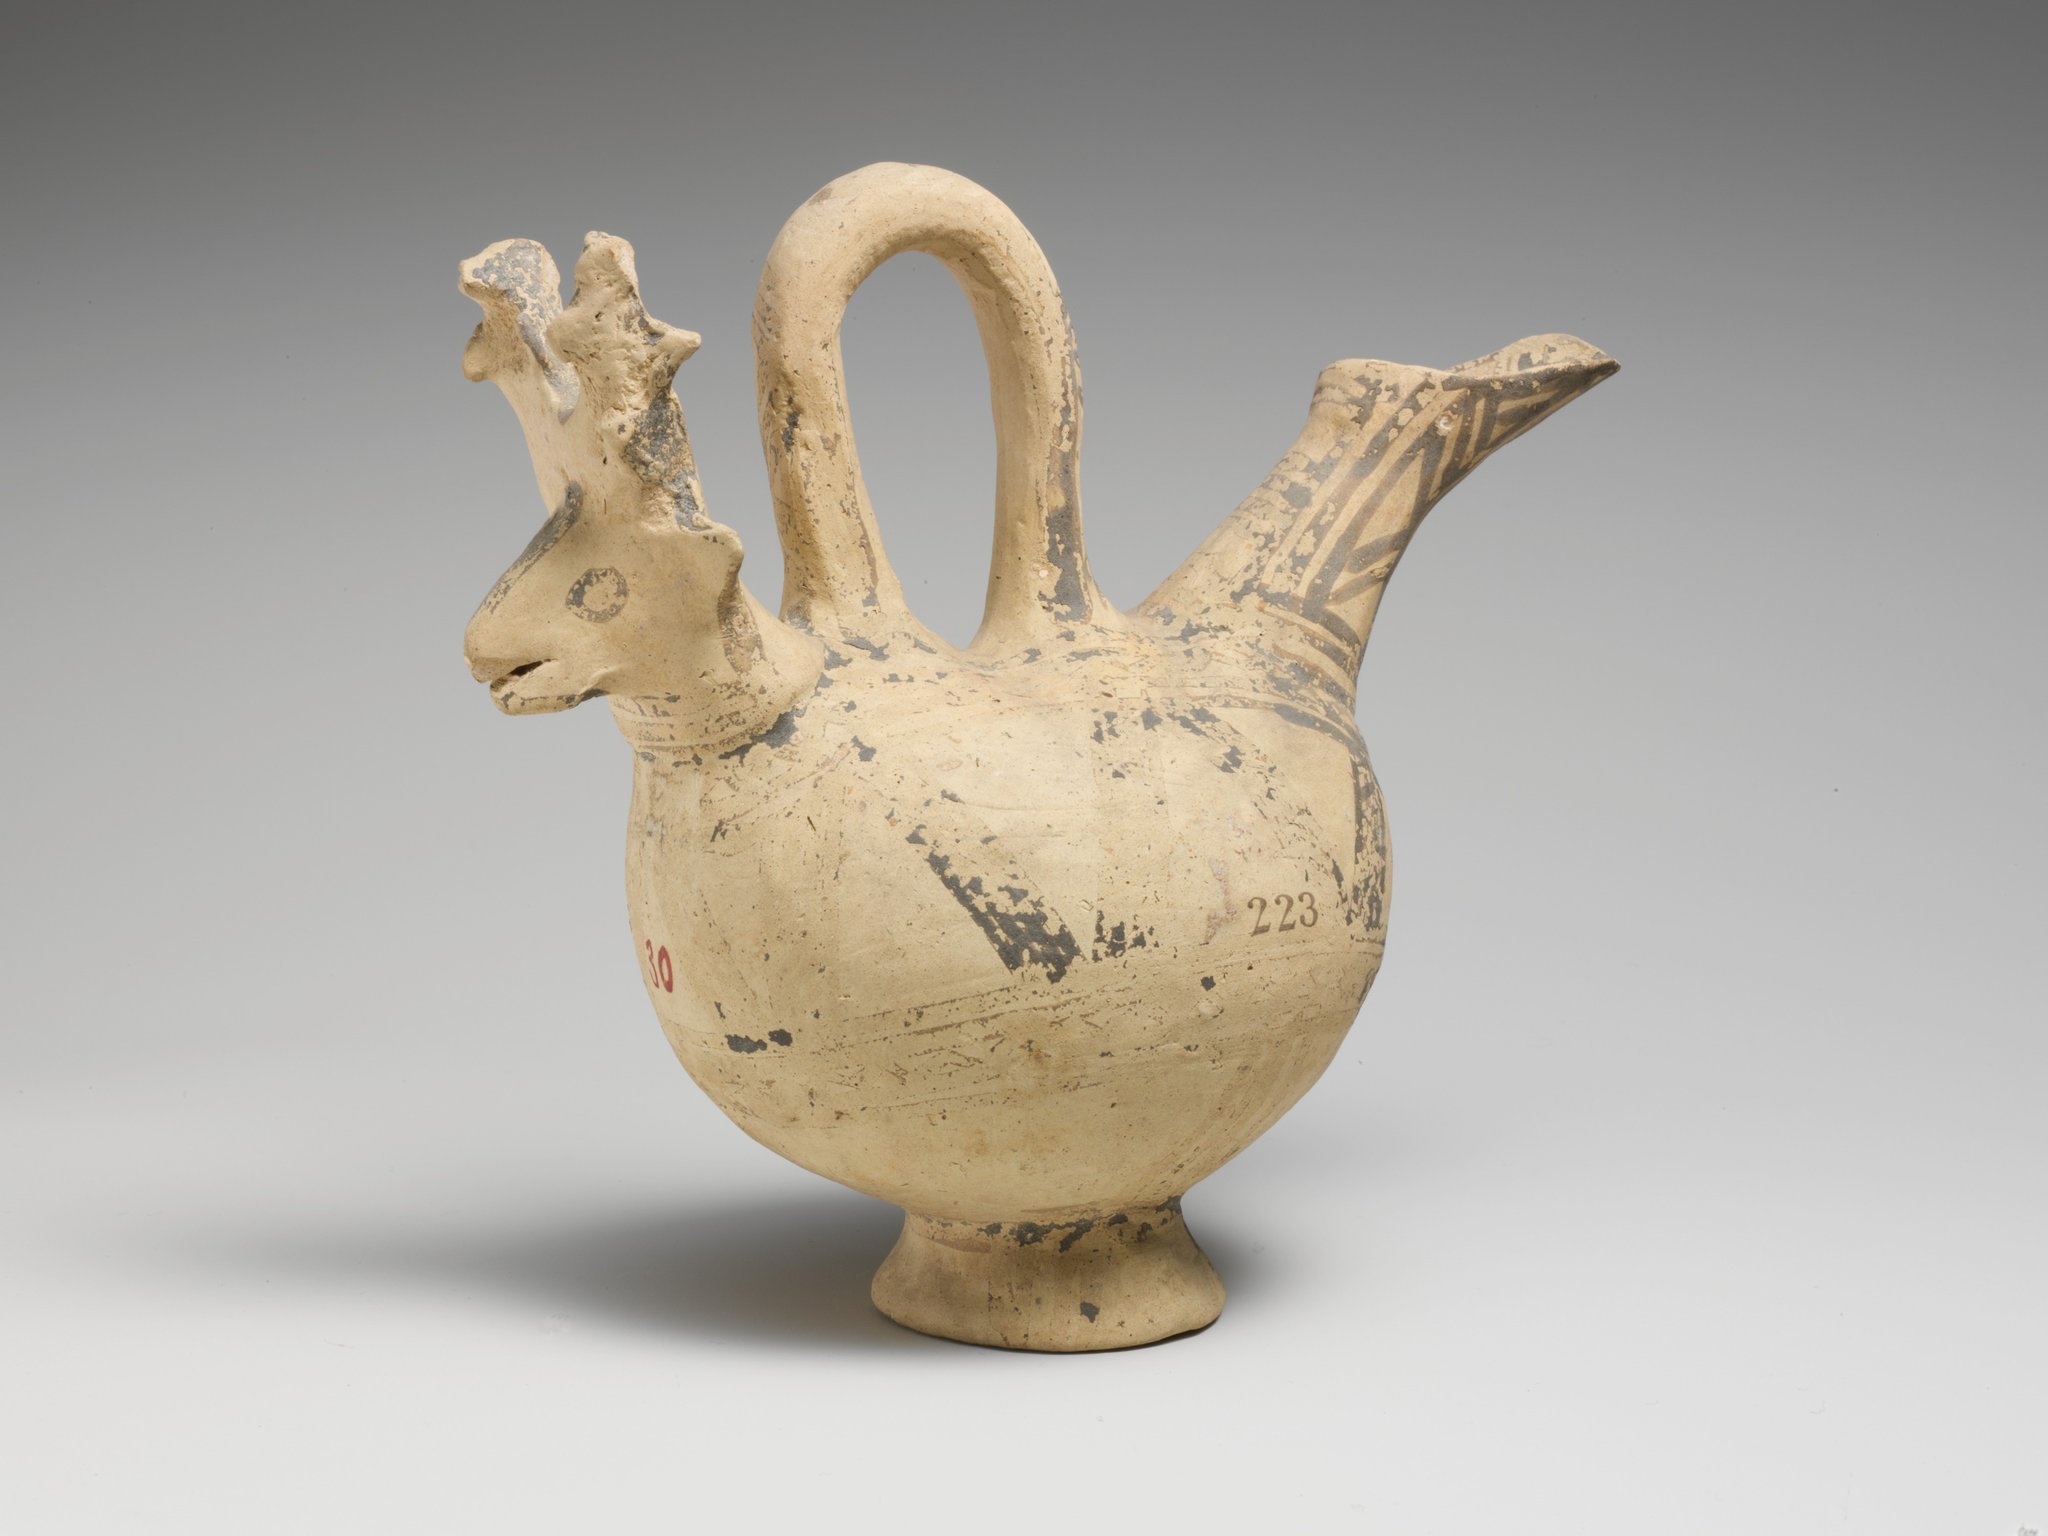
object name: vase in the form of an animal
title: Terracotta zoomorphic askos (vessel)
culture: cypriot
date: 1900-1600 BCE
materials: terracotta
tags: deer